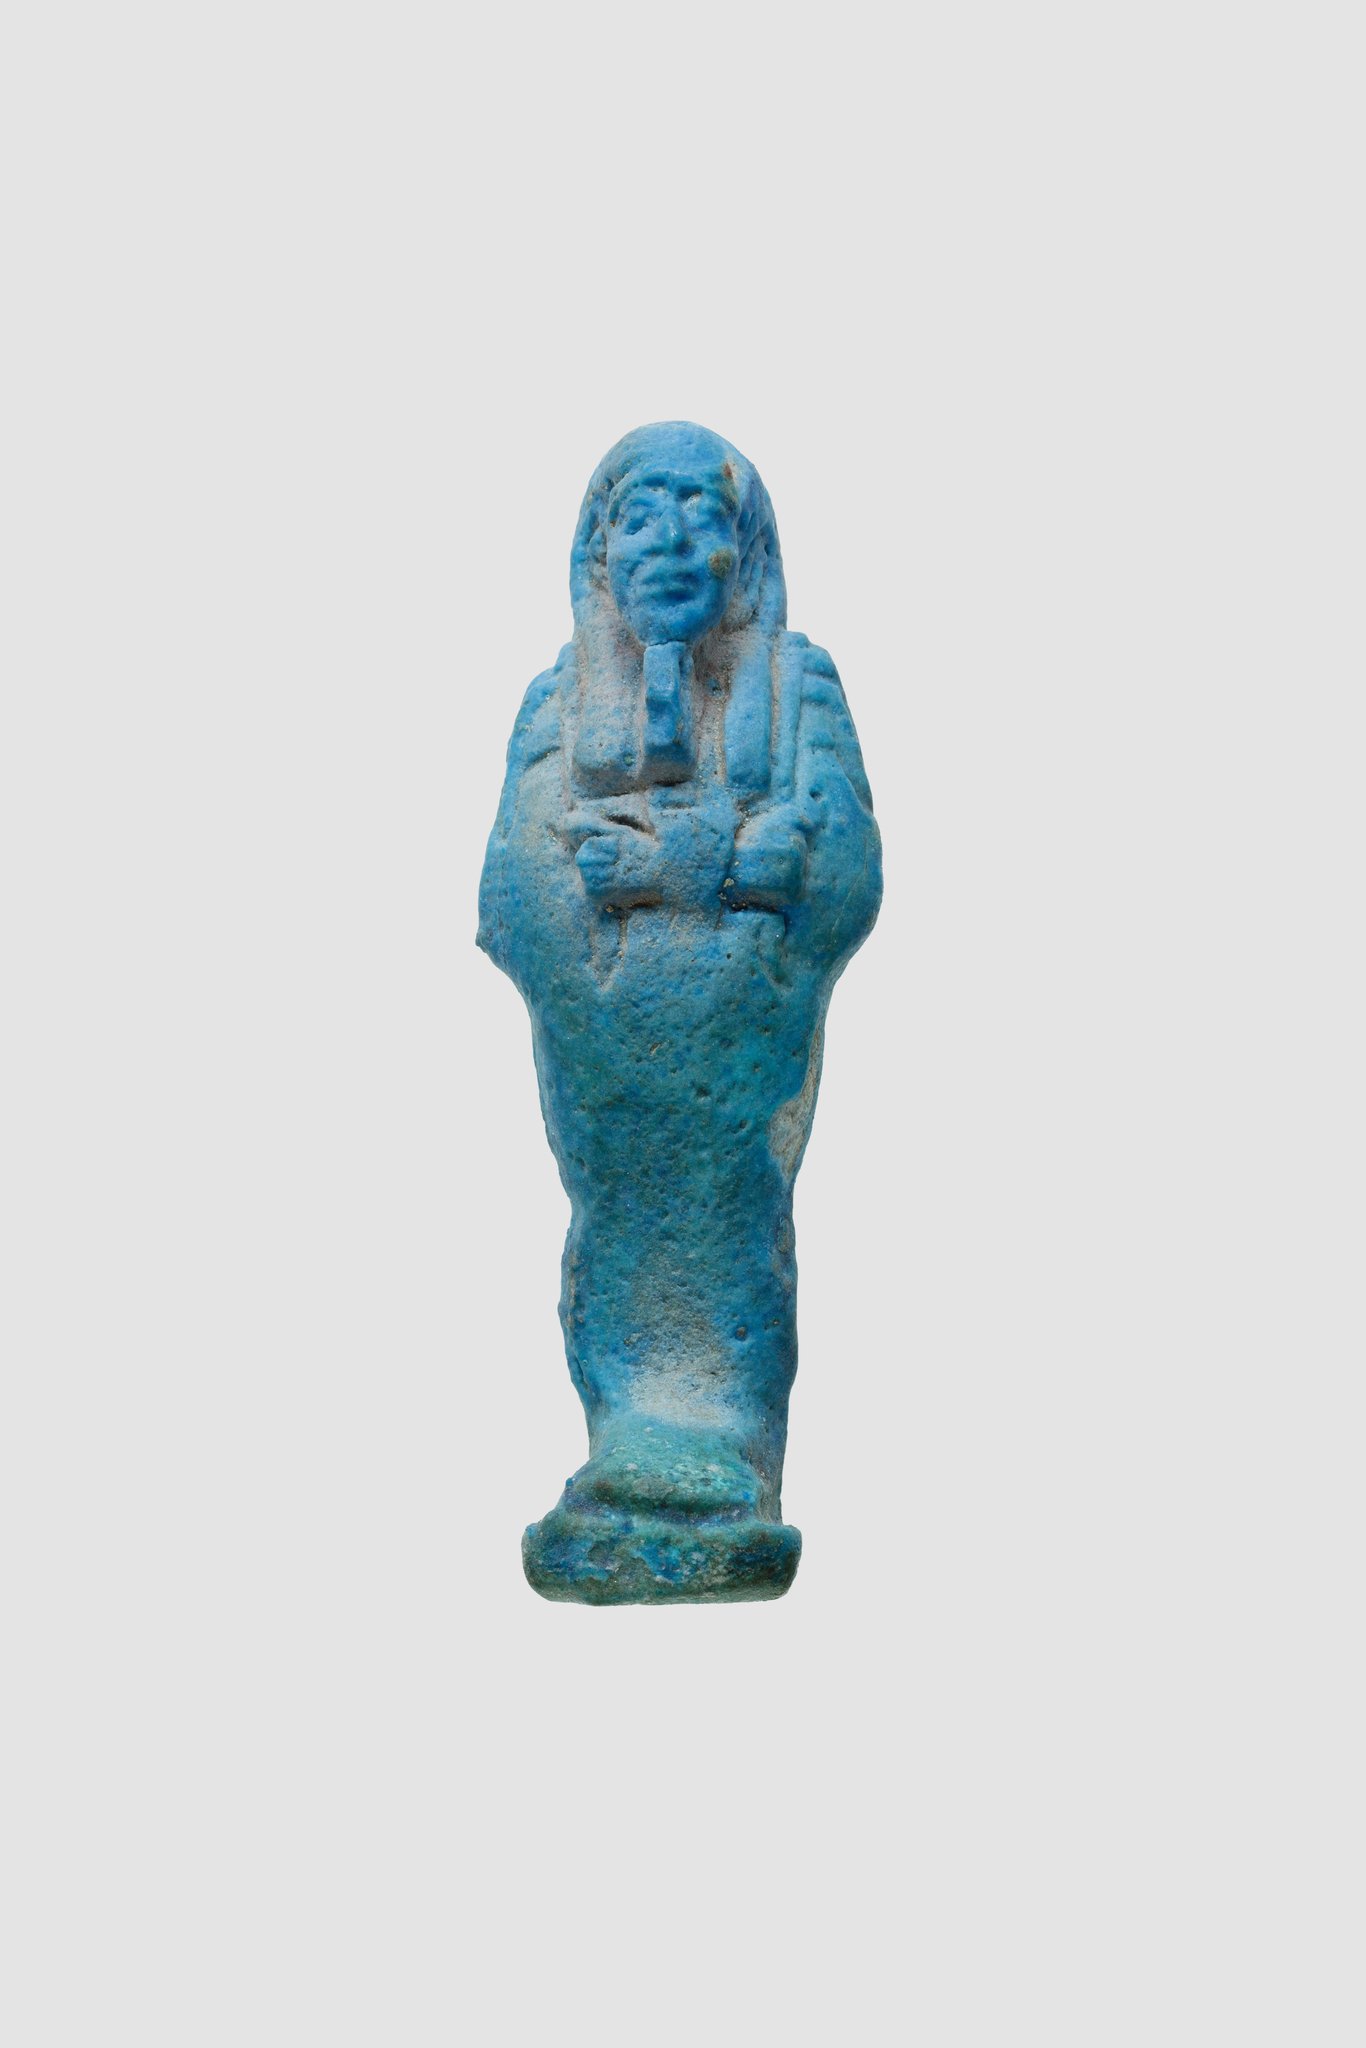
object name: shabti, nespekashuty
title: Uninscribed shabti from tomb of Nespekashuty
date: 664-610 BCE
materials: faience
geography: egypt